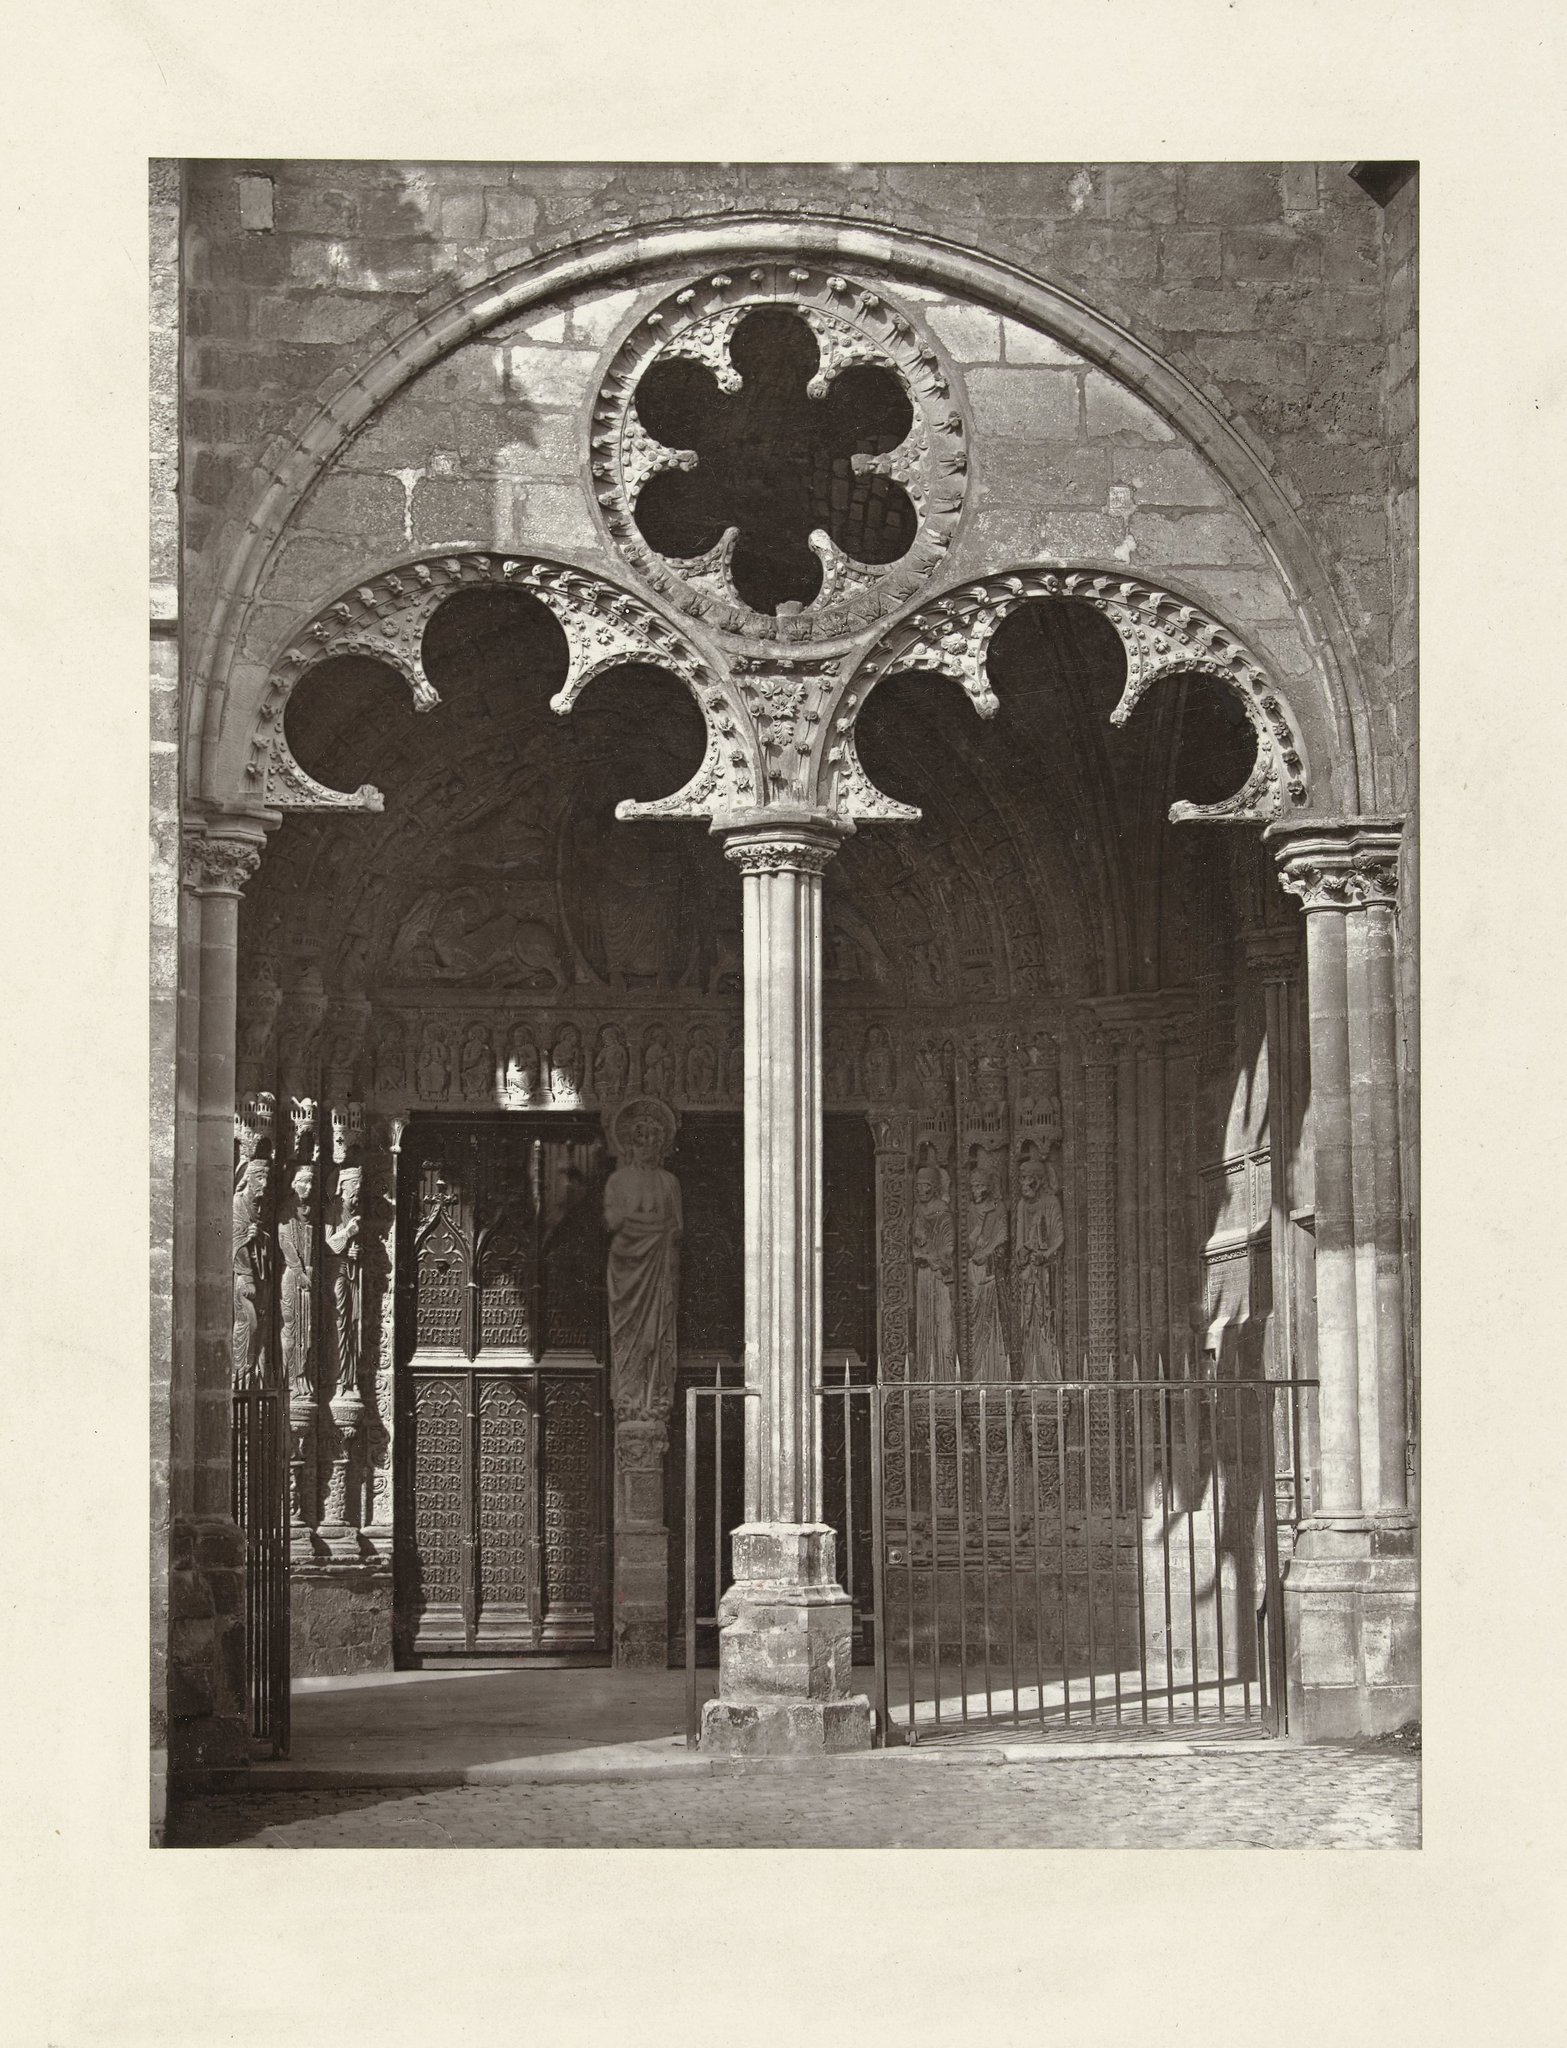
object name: photograph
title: Portaal van de kathedraal van Bourges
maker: séraphin-médéric mieusement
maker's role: fotograaf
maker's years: 1840-1905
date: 1870-1890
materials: cardboard, paper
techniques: carbon print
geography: bourges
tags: parts of church exterior and annexes: portal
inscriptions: inscription: ‘Cathédrale de Bourges’